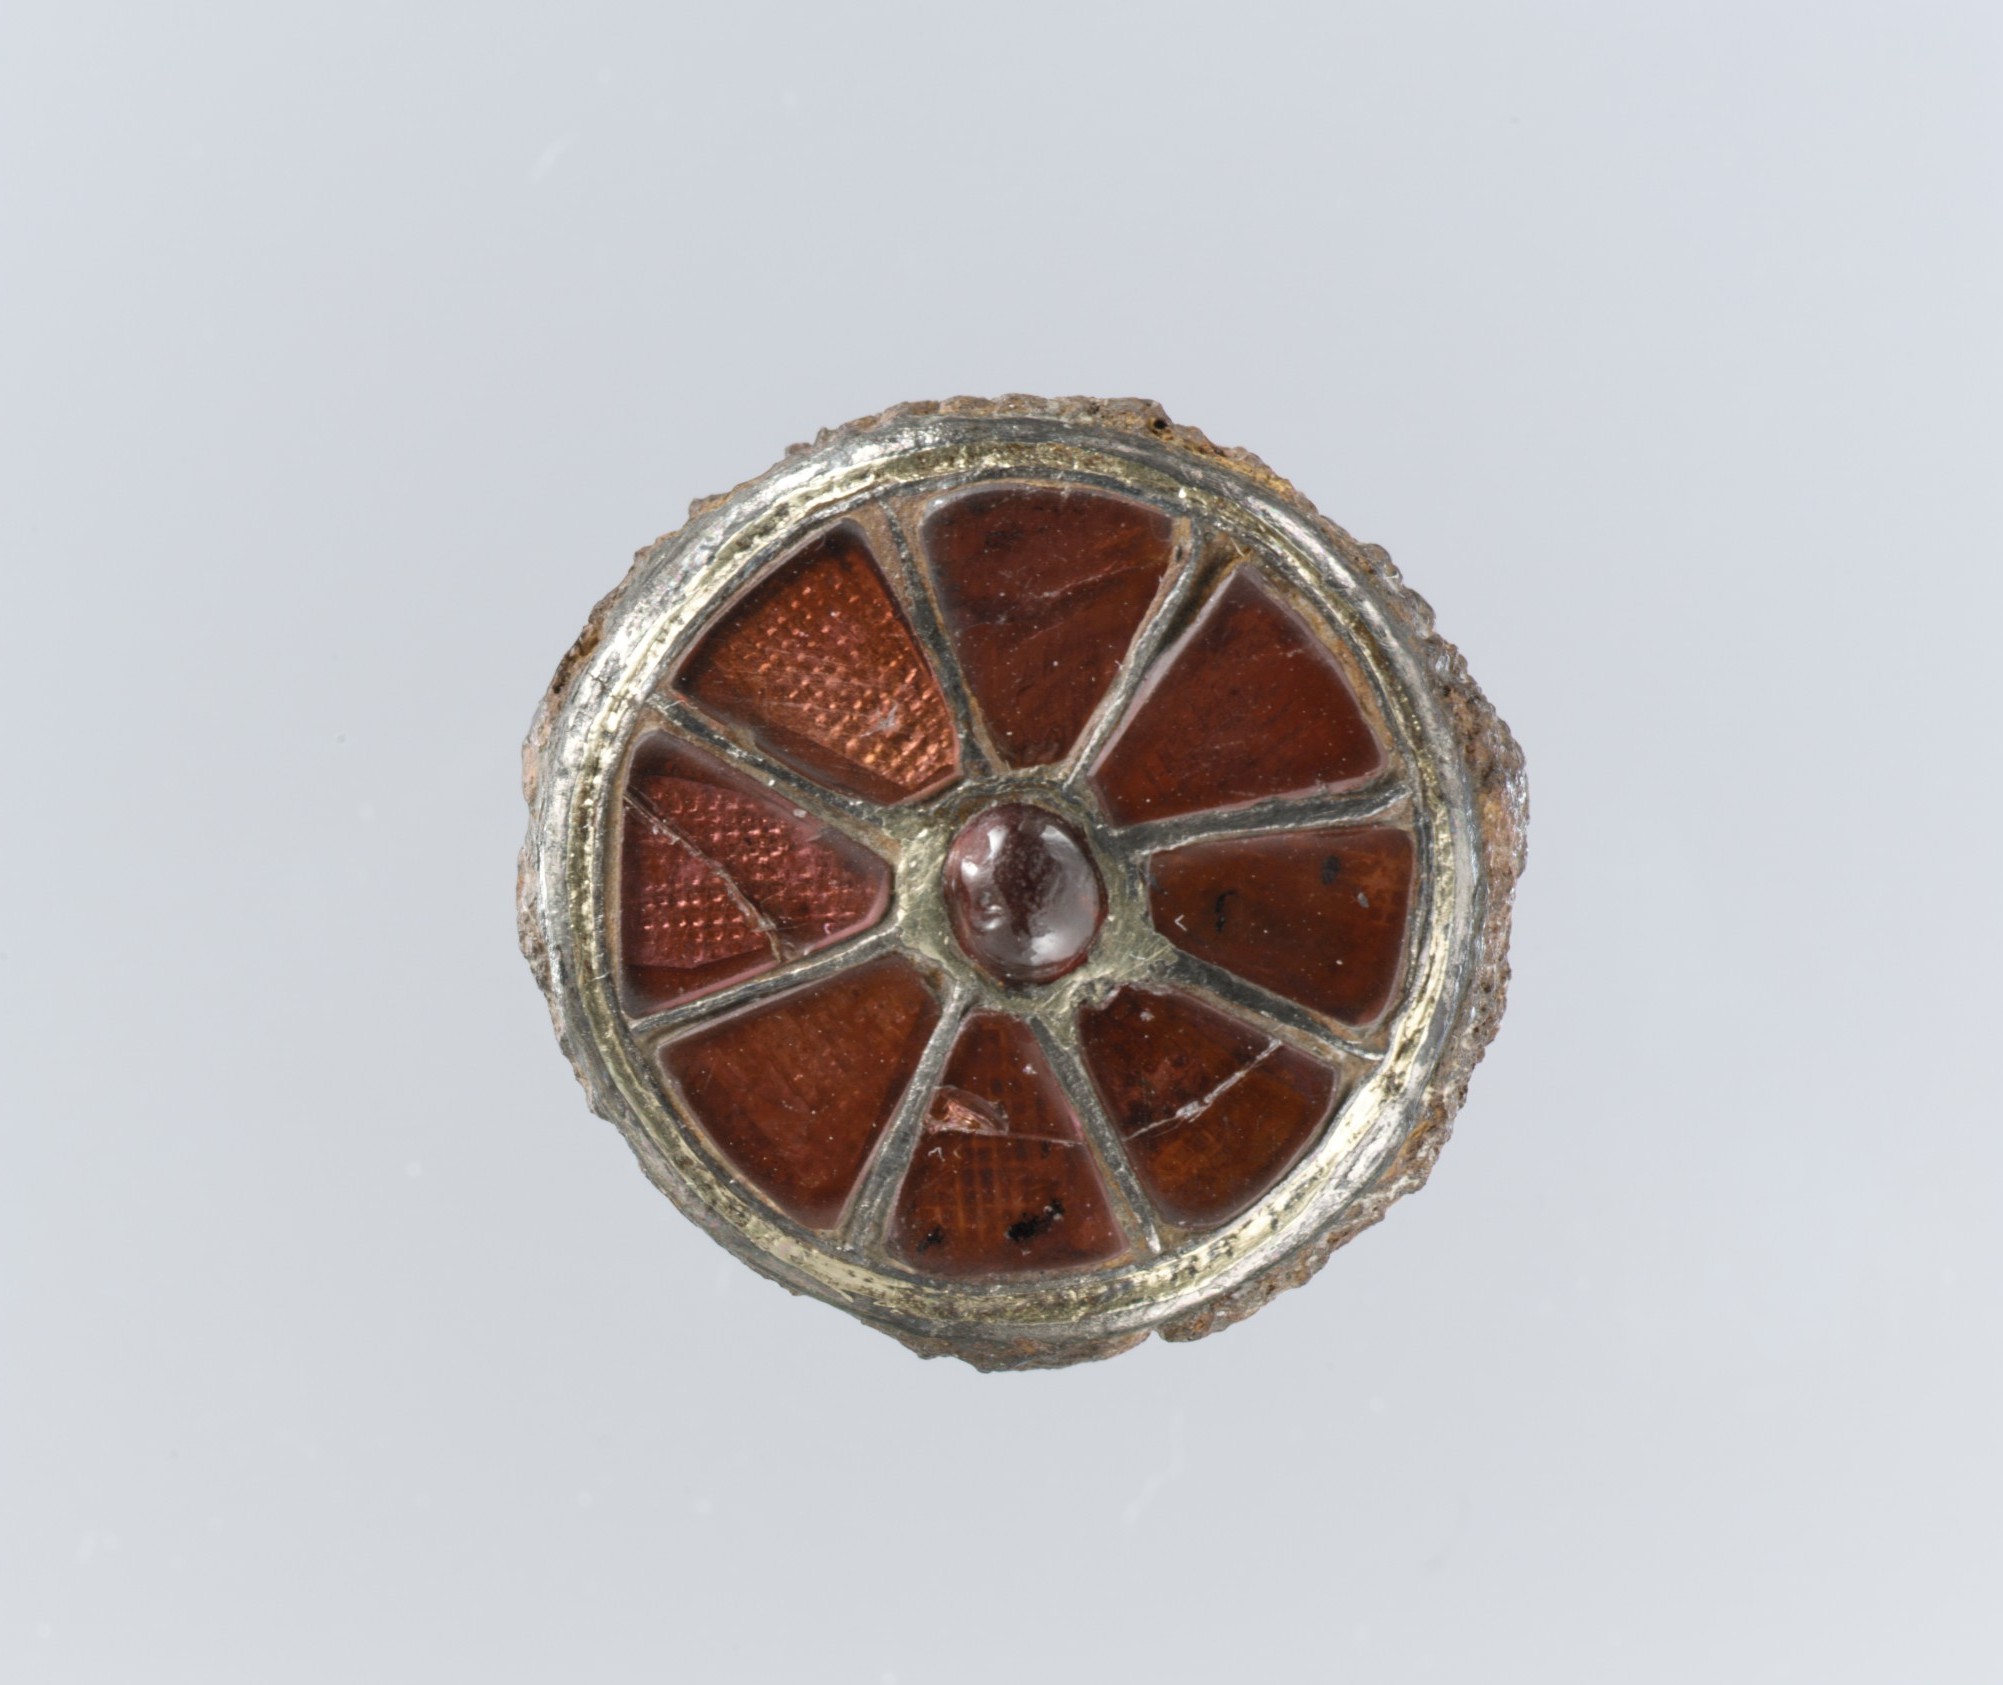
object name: brooch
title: Disk Brooch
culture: frankish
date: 501-600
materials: foil, gemstone, garnet, silver gilt